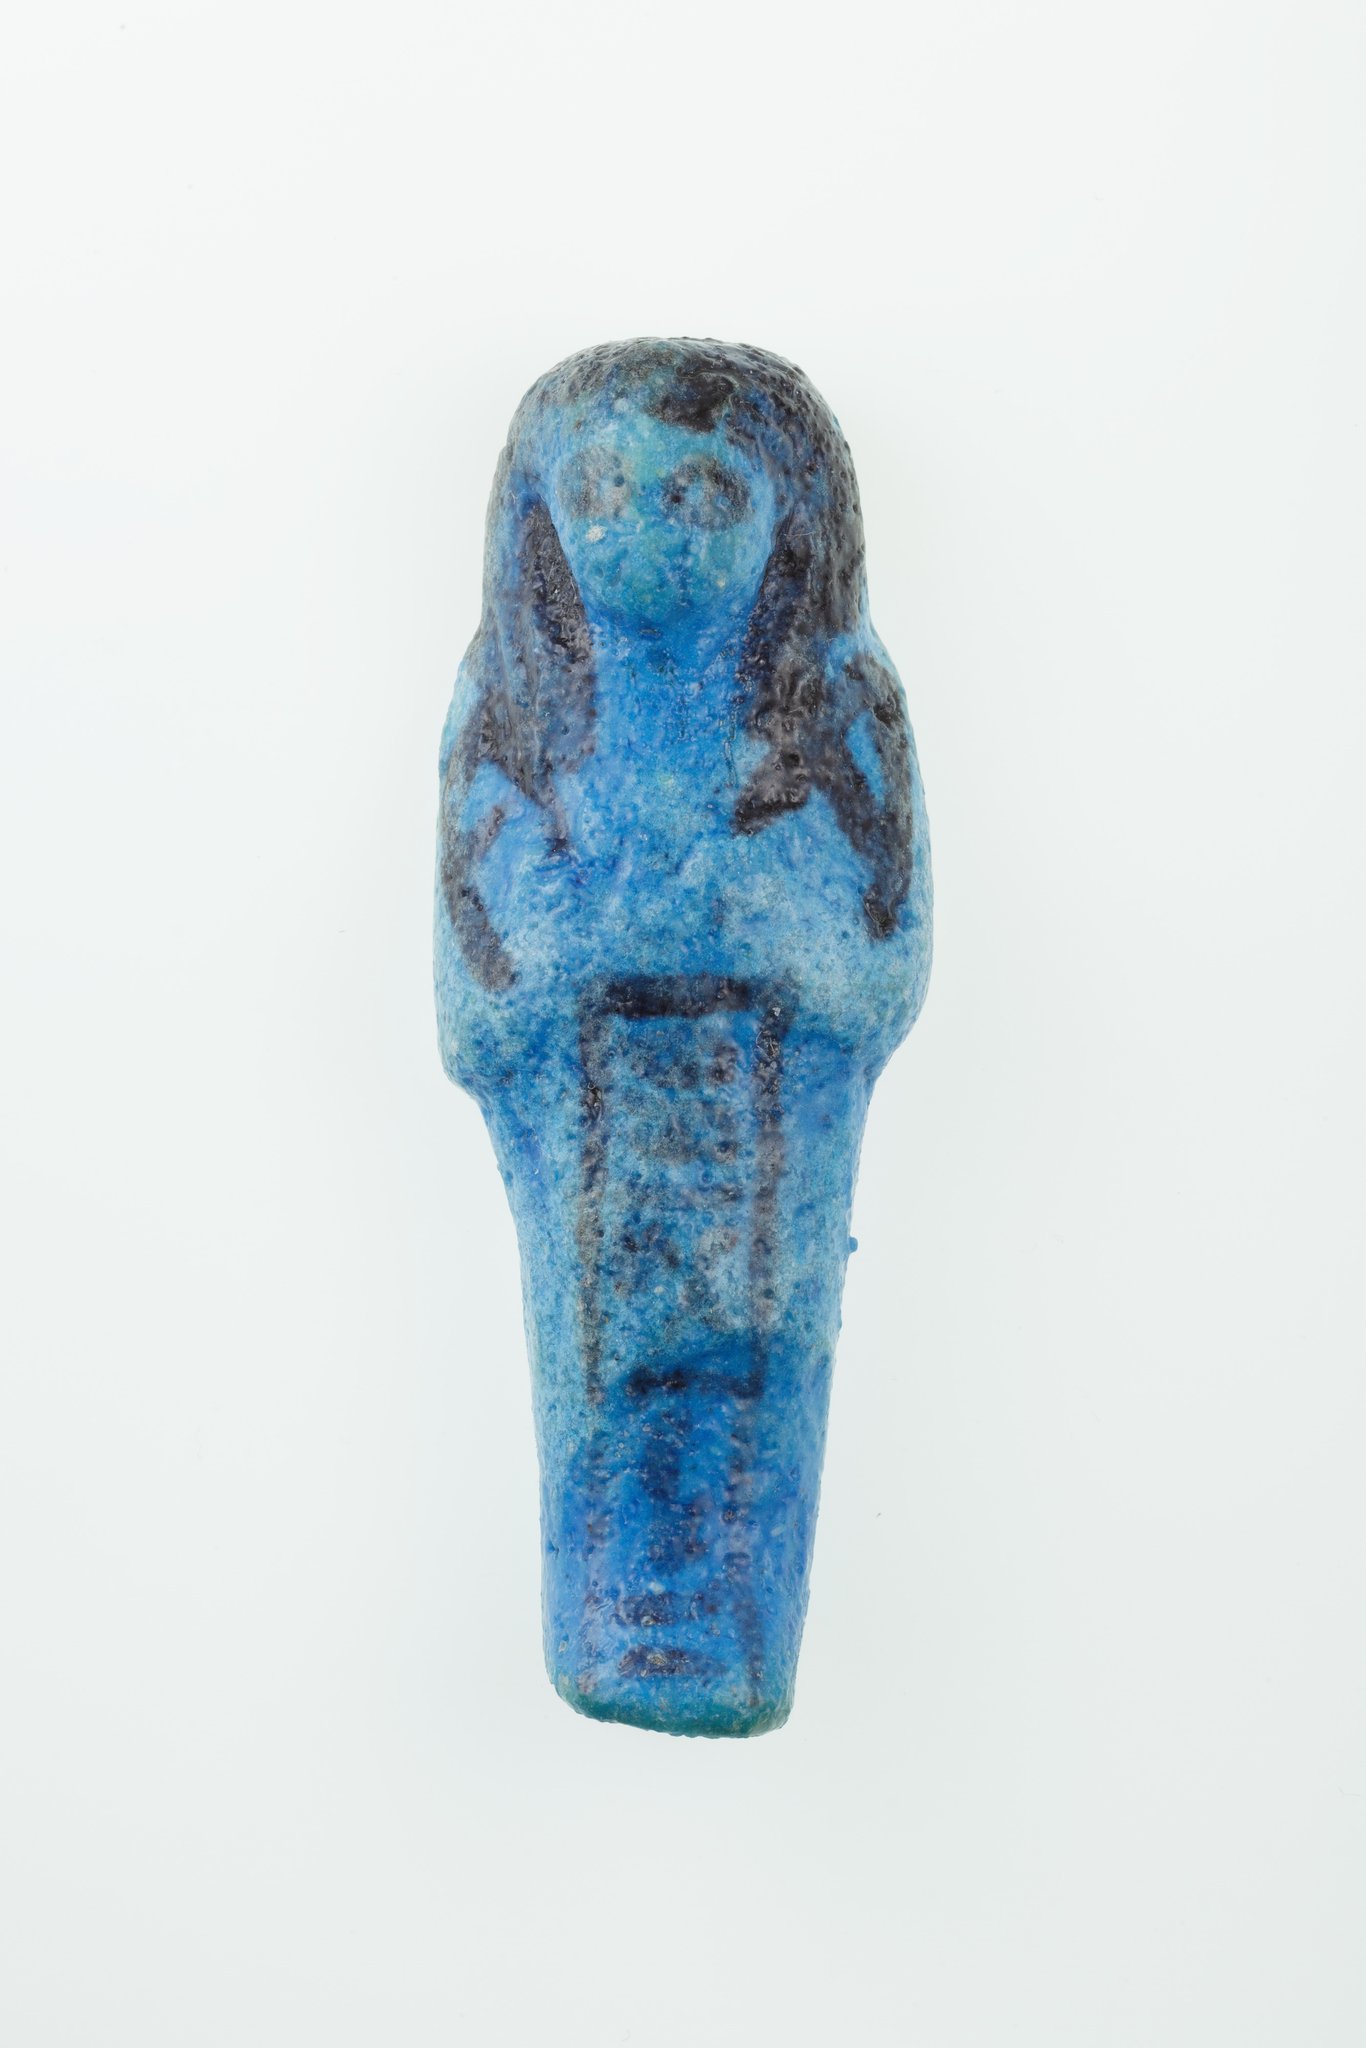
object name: shabti, worker, nauny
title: Worker Shabti of Nauny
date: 1050 BCE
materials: faience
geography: egypt